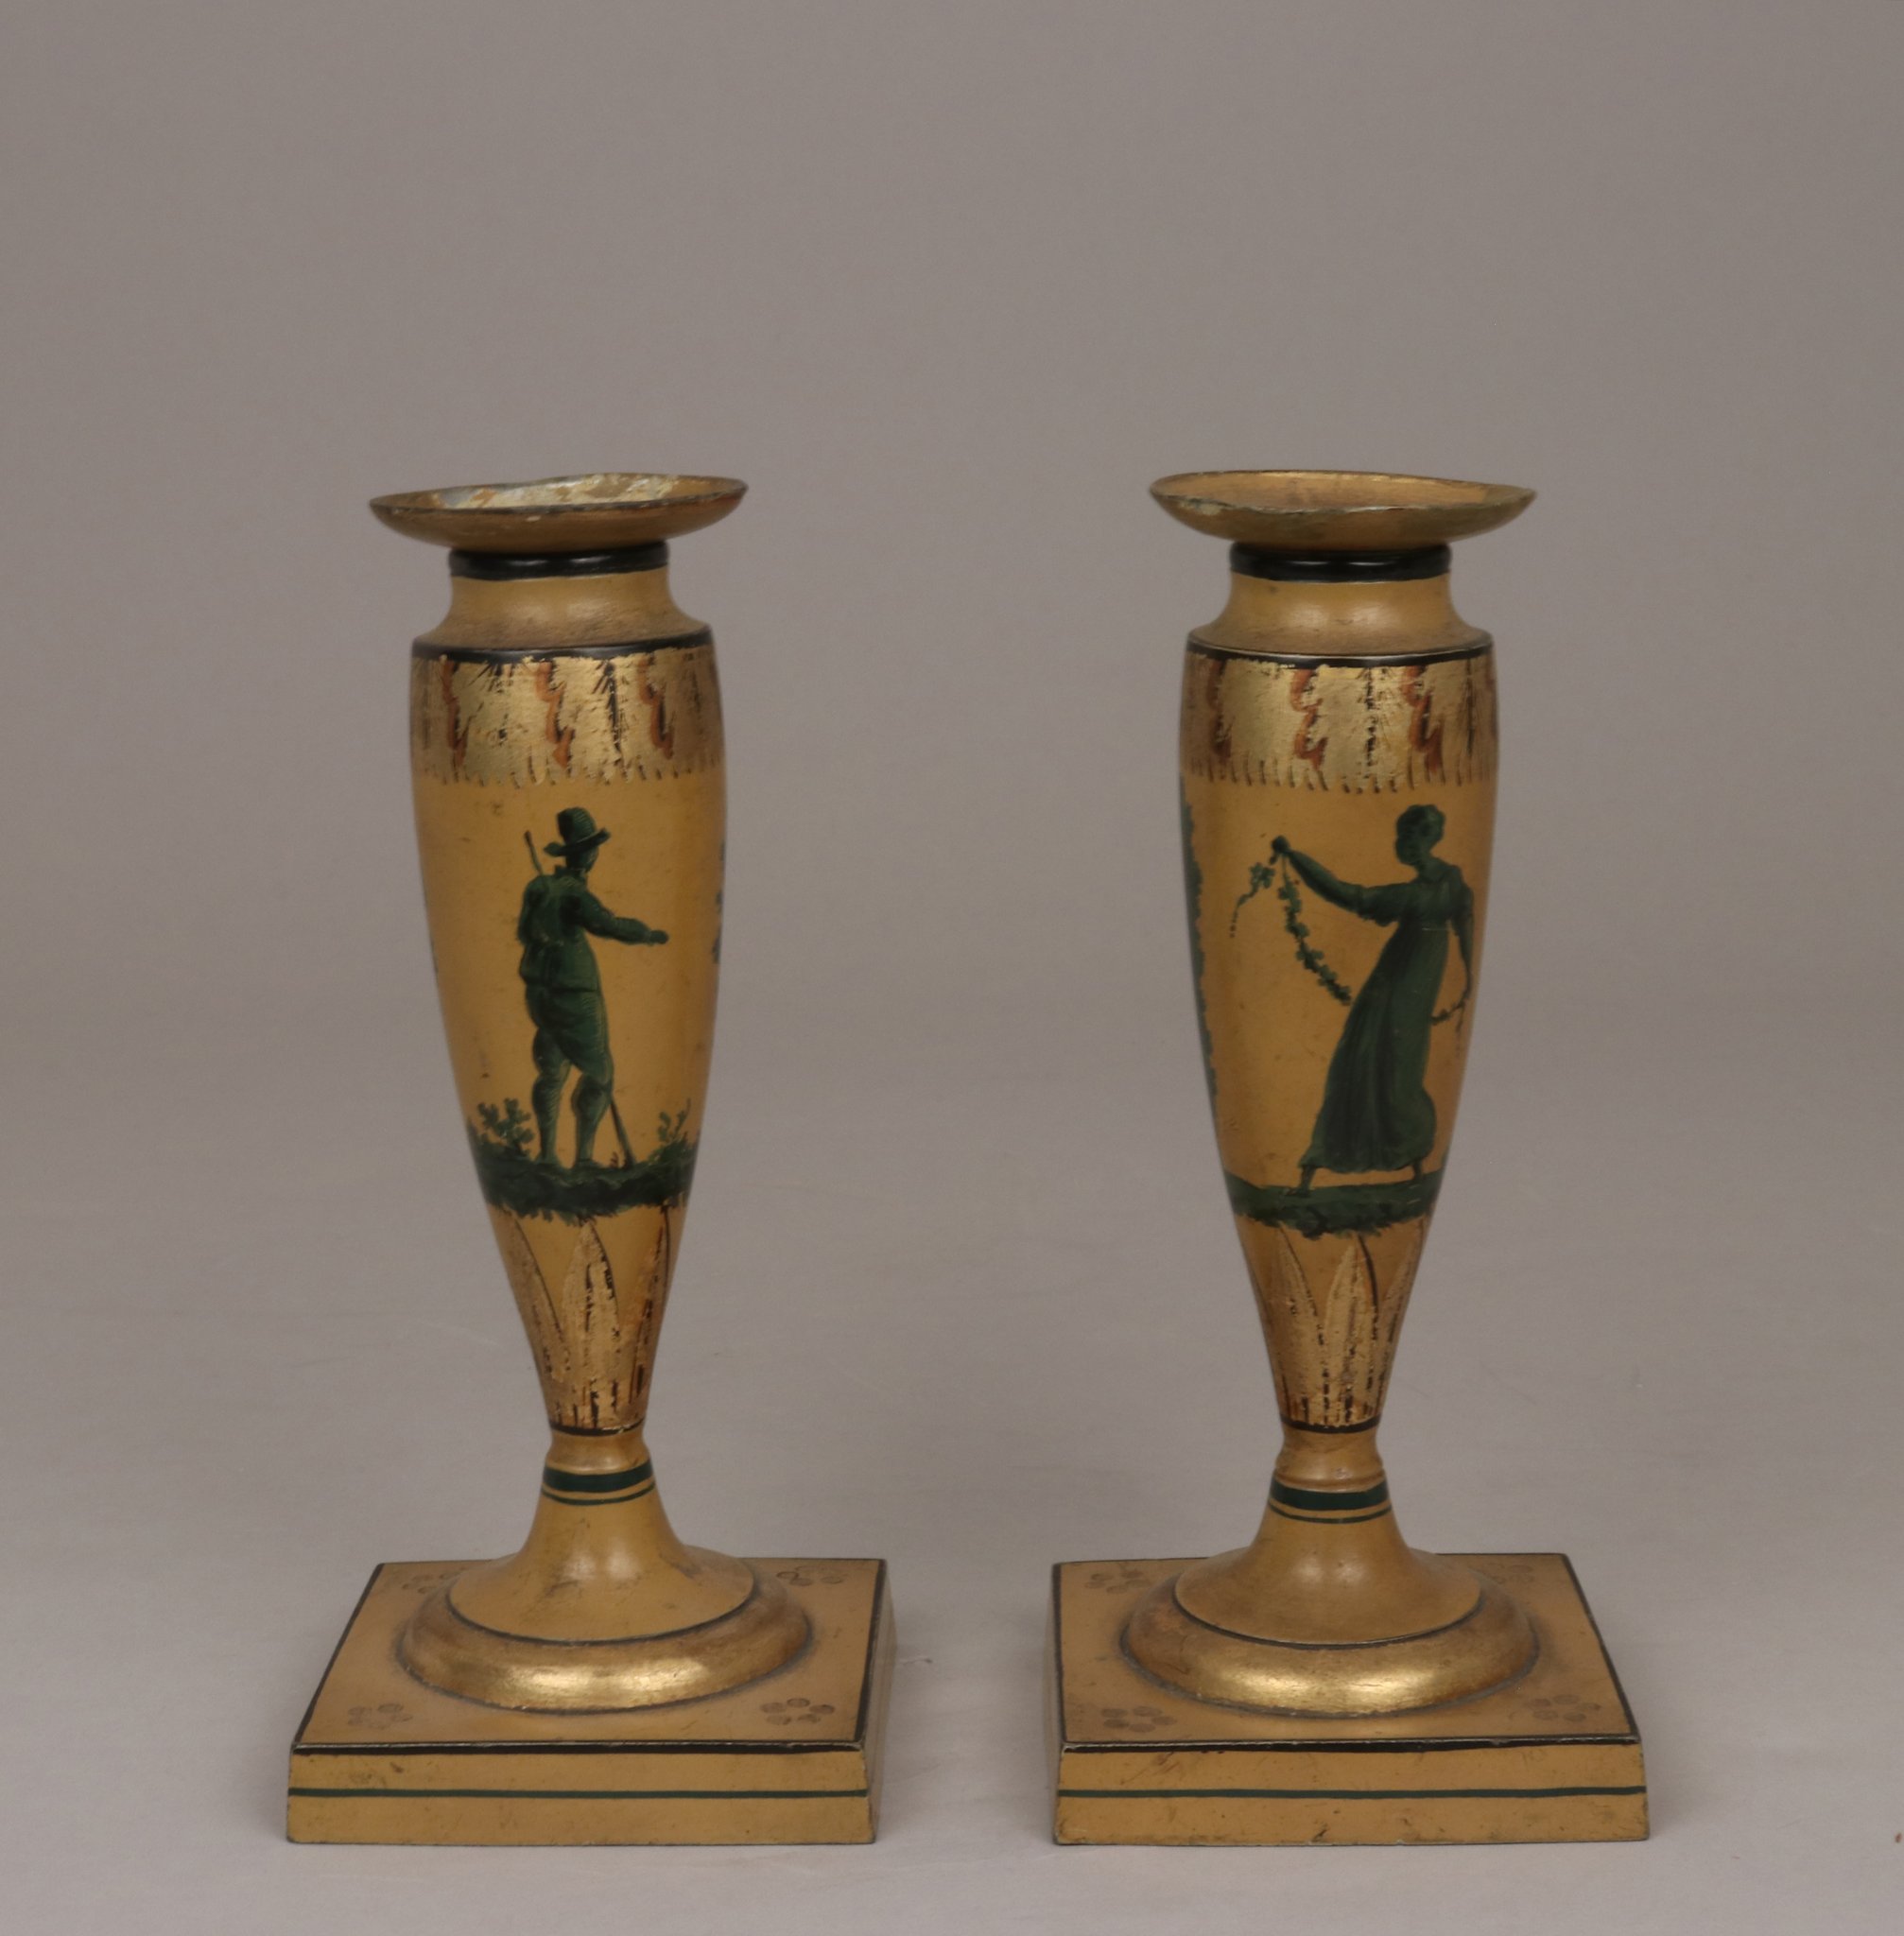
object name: candlestick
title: Pair of candlesticks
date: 1767-1833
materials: pewter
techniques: painting